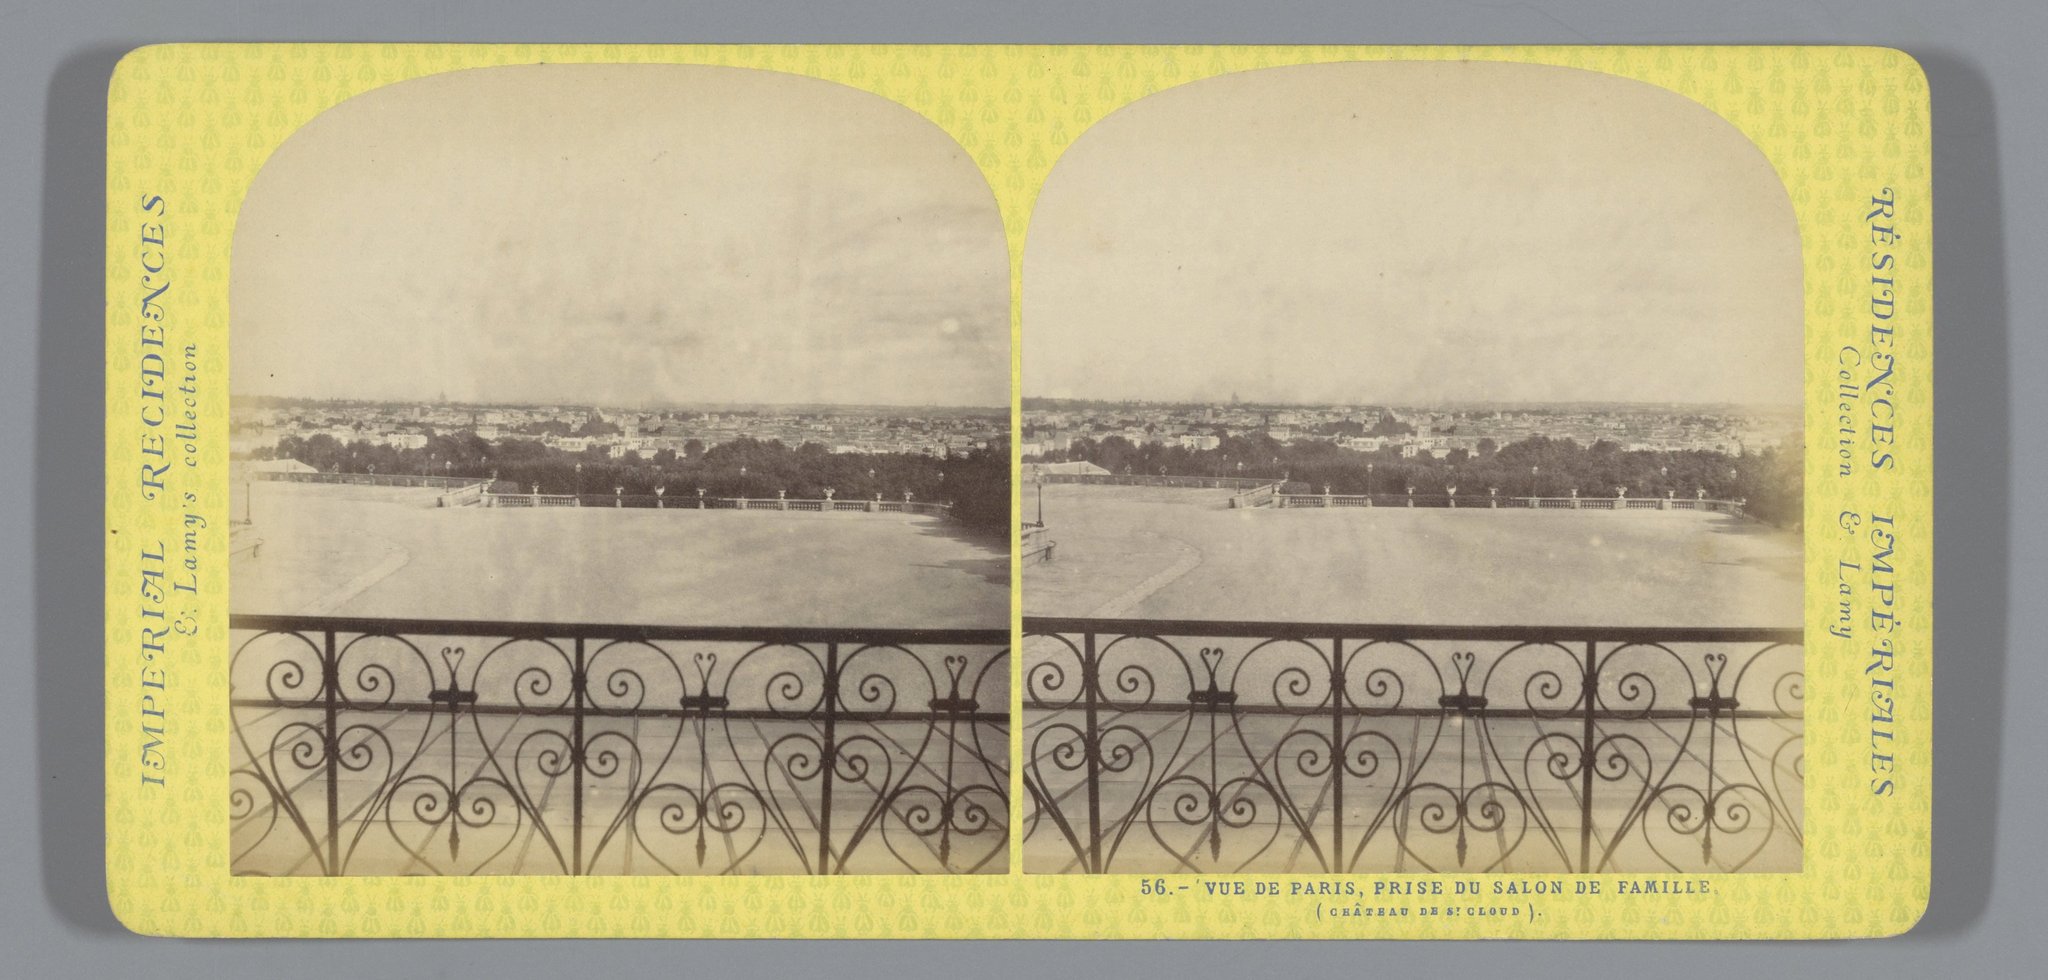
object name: stereograph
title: Imperial Residences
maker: ernest eléonor pierre lamy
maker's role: publisher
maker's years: 1828-1900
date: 1860-1870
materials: cardboard, photographic support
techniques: albumen print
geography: château de saint-cloud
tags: city-view in general; 'veduta', paris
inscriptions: inscription: ‘E. Lamy's collection’, number: ‘56.’